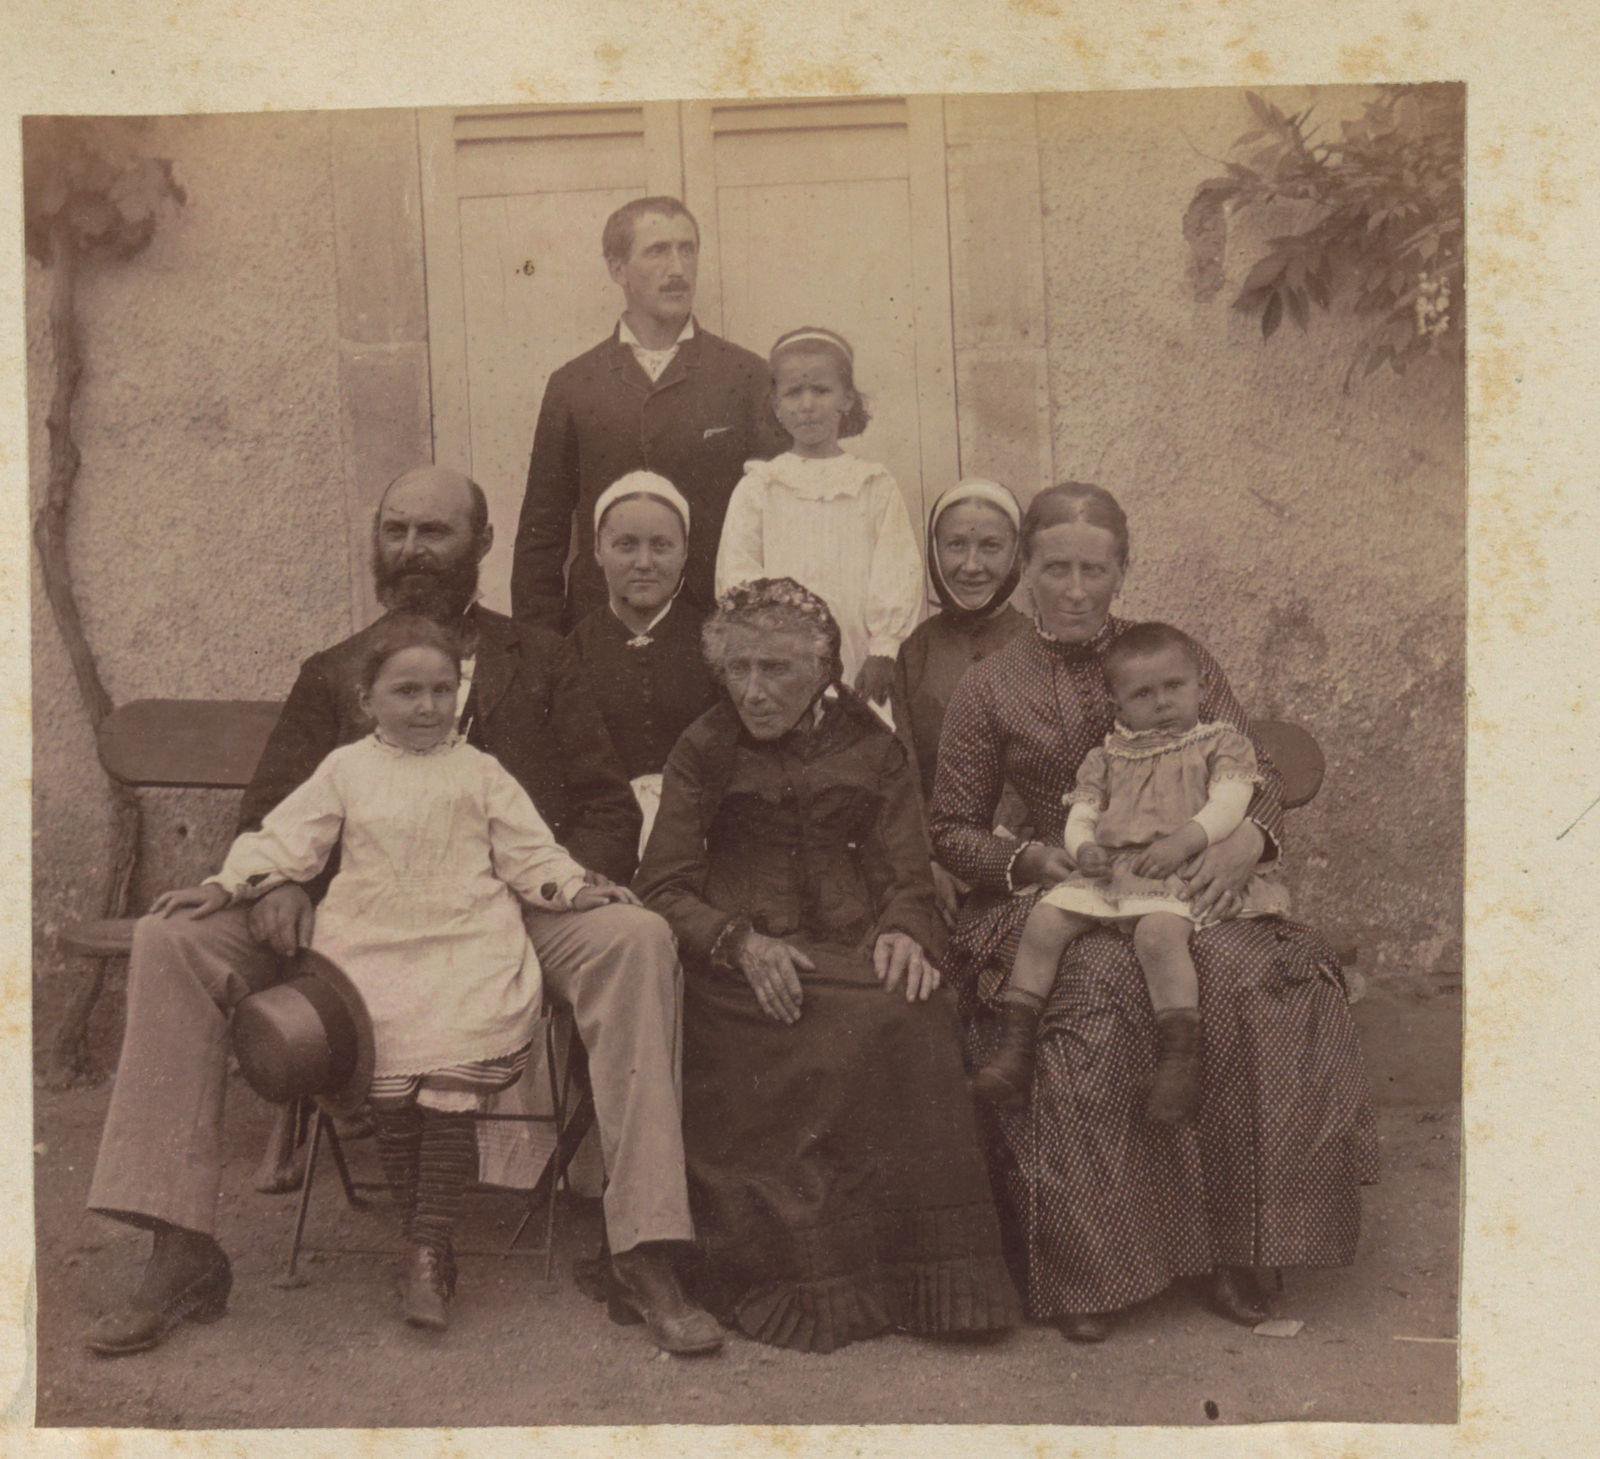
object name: photograph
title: Groepsportret van de familie Van Crayelynghe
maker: Anonymous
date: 1807-1885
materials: photographic support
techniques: albumen print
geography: france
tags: three generations (family group)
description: Onderdeel van Album van een Franse amateurfotograaf met opnames van familie, militairen, industrie, landschappen en bezienswaardigheden in Frankrijk.